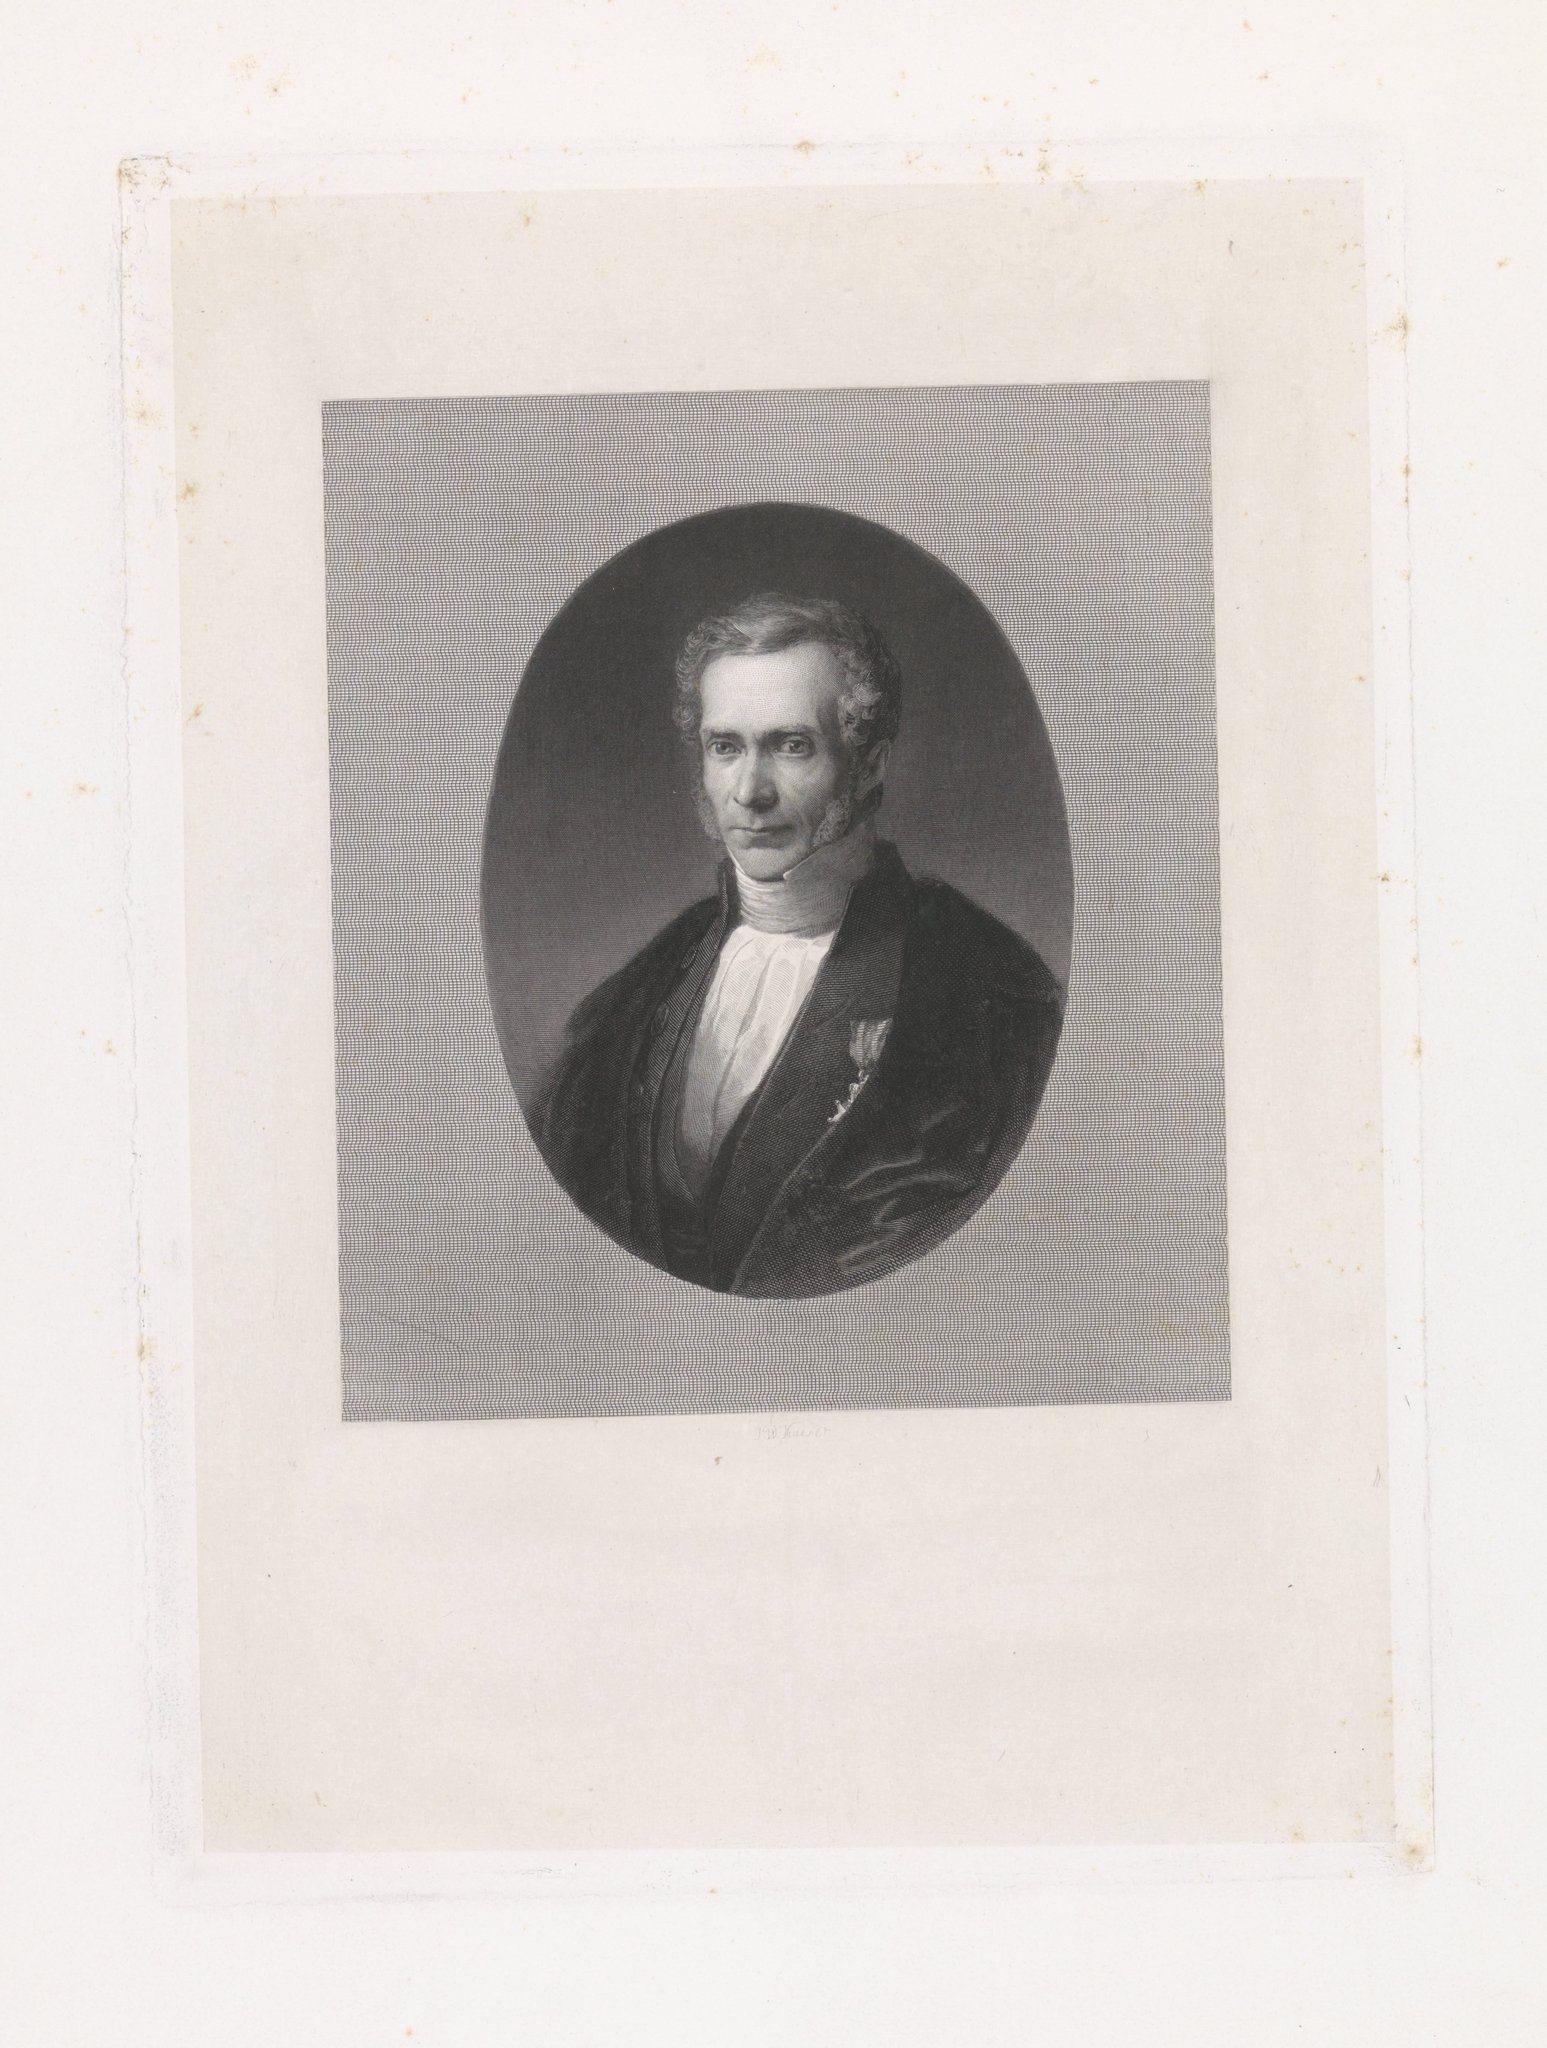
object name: print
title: Portret van Frederik Kaiser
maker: johann wilhelm kaiser (i)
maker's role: draughtsman, print maker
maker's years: 1813-1900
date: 1823-1900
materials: paper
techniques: etching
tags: amsterdam, leiden, frederik kaiser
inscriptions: collector's mark: Lugt 2228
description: Portretbuste in een ovaal naar links van de sterrenkundige Frederik Kaiser. Op zijn borst heeft hij een lintje.